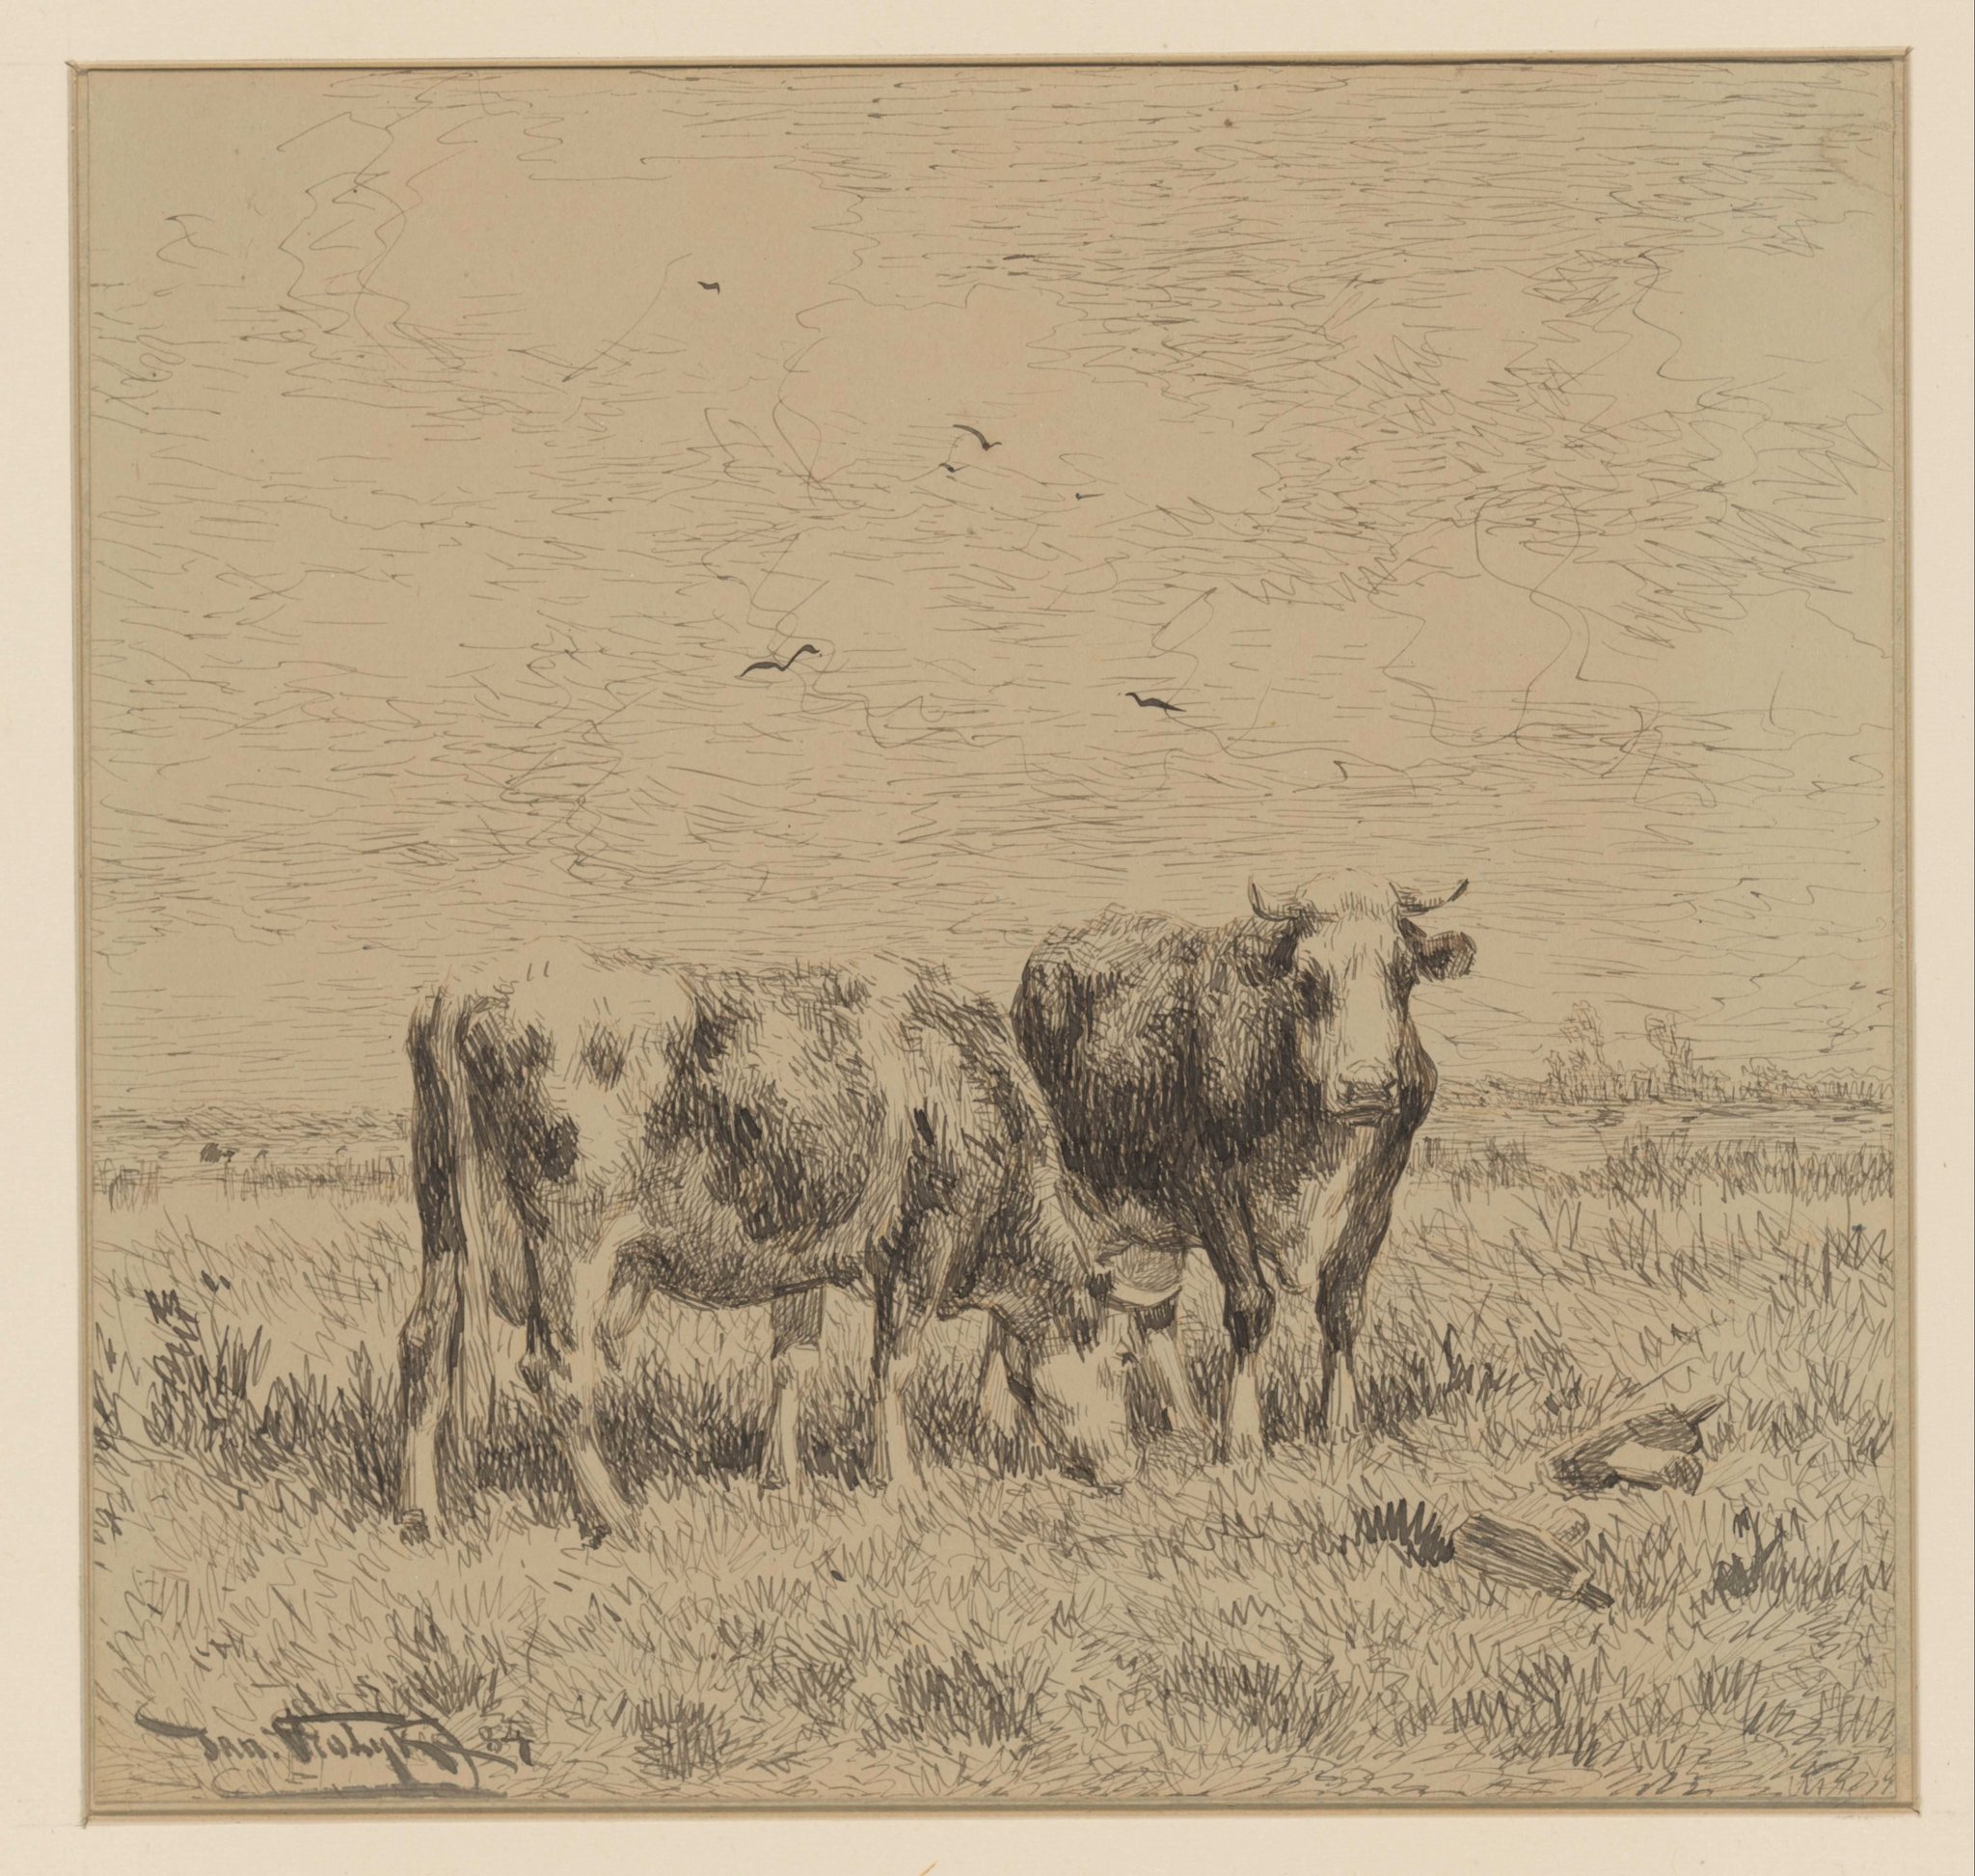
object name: drawing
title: Twee koeien in een weiland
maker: jan vrolijk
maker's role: draughtsman, painter, print maker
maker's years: 1846-1894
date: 1884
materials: ink, paper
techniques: pen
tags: cow, meadow, pasture